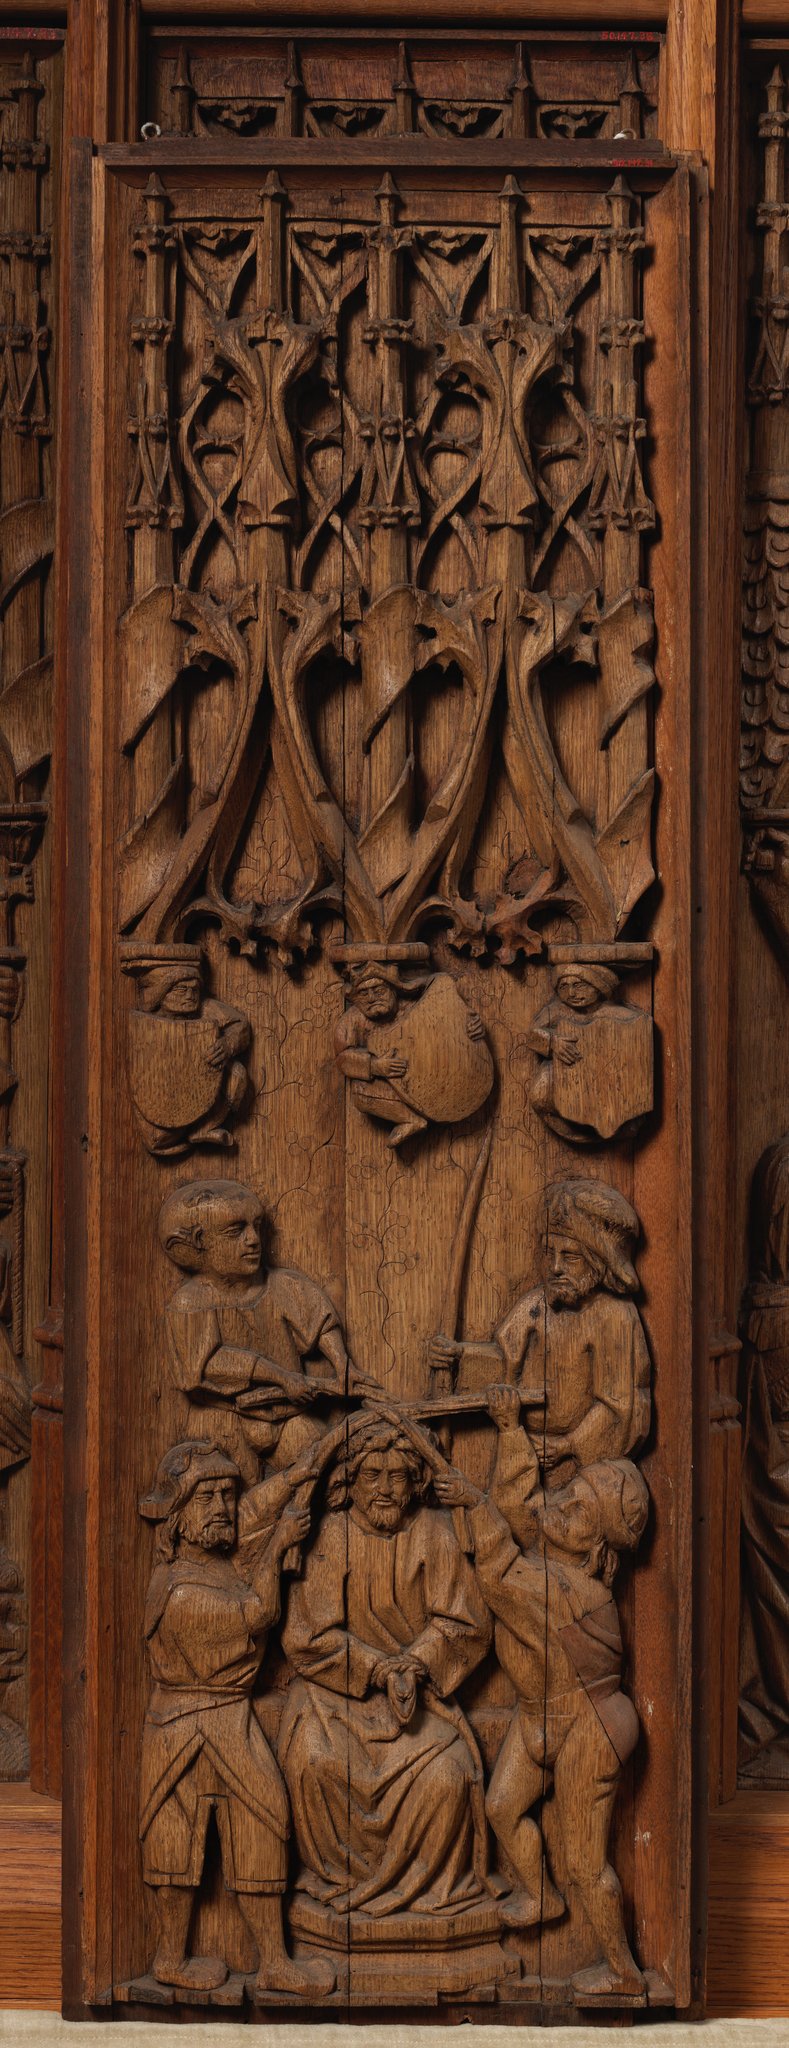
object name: panel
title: Panel with the Crown of Thorns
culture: french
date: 1501-1533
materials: wood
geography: france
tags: suffering,men,jesus